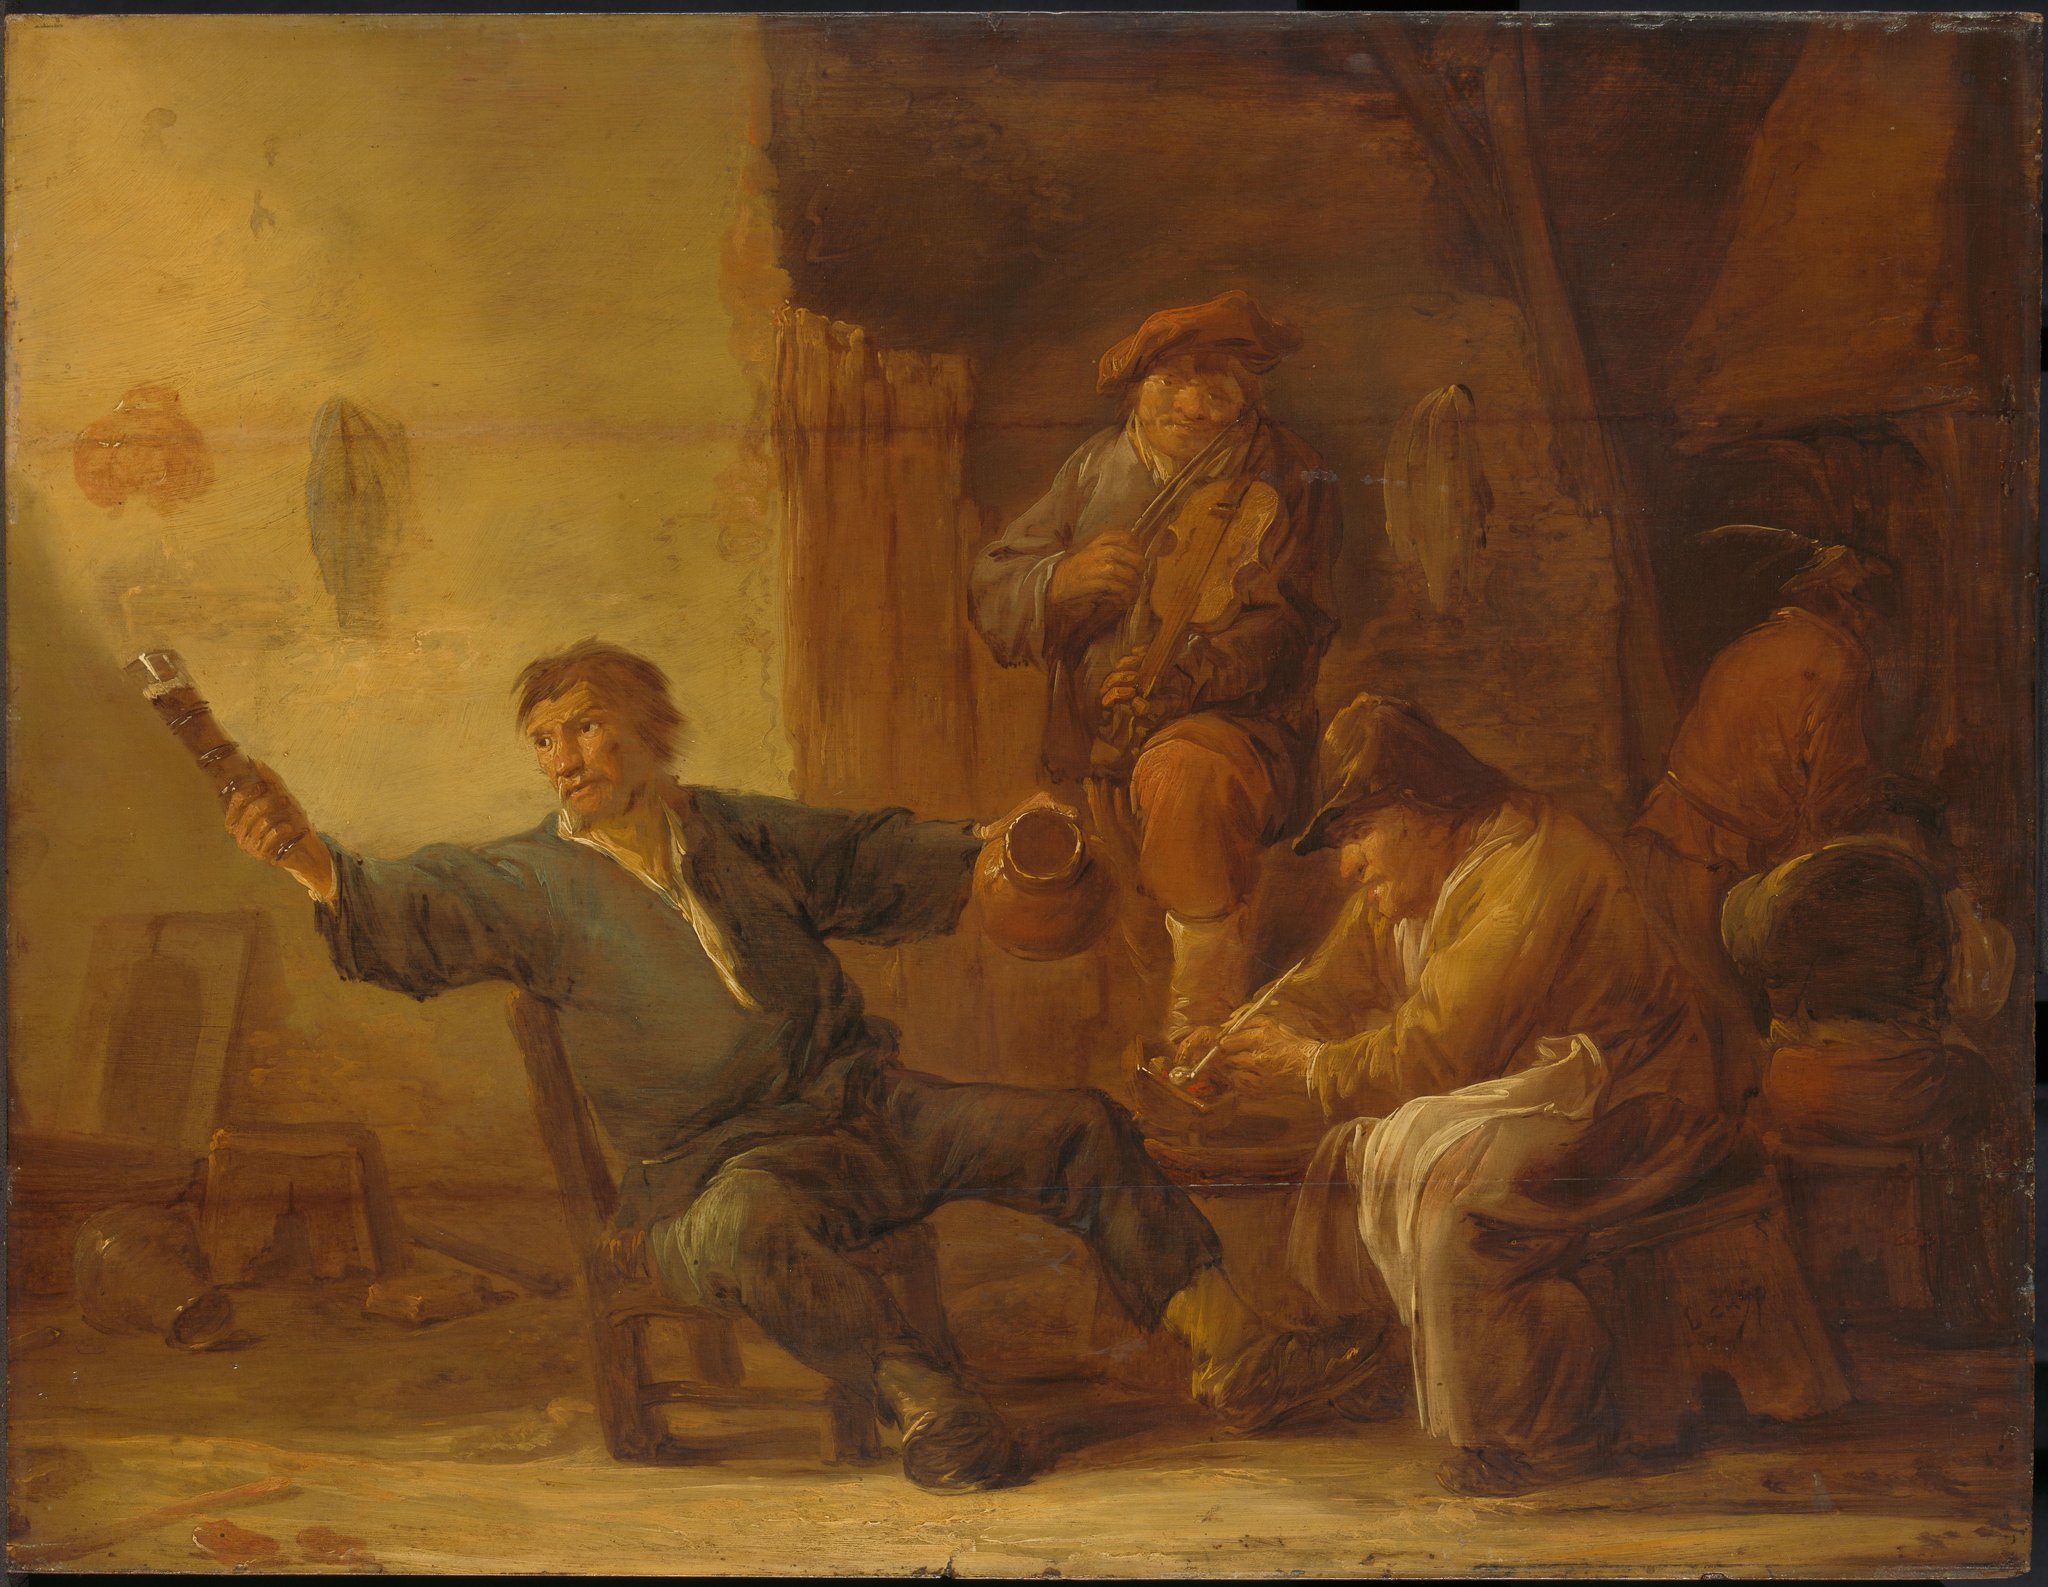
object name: painting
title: Interior of a Peasant Hut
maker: benjamin gerritsz cuyp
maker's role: draughtsman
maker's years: 1612-1652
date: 1645-1652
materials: oil, panel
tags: inn, coffee-house, public house, etc., drinking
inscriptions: signature, lower right, on the stool: ‘B cuyp’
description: Interieur van een herberg met links een man met een kruik en glas, rechts steekt een man zijn pijp aan. Tussen hen speelt een man op zijn viool, rechts enkele figueren bij de haard.